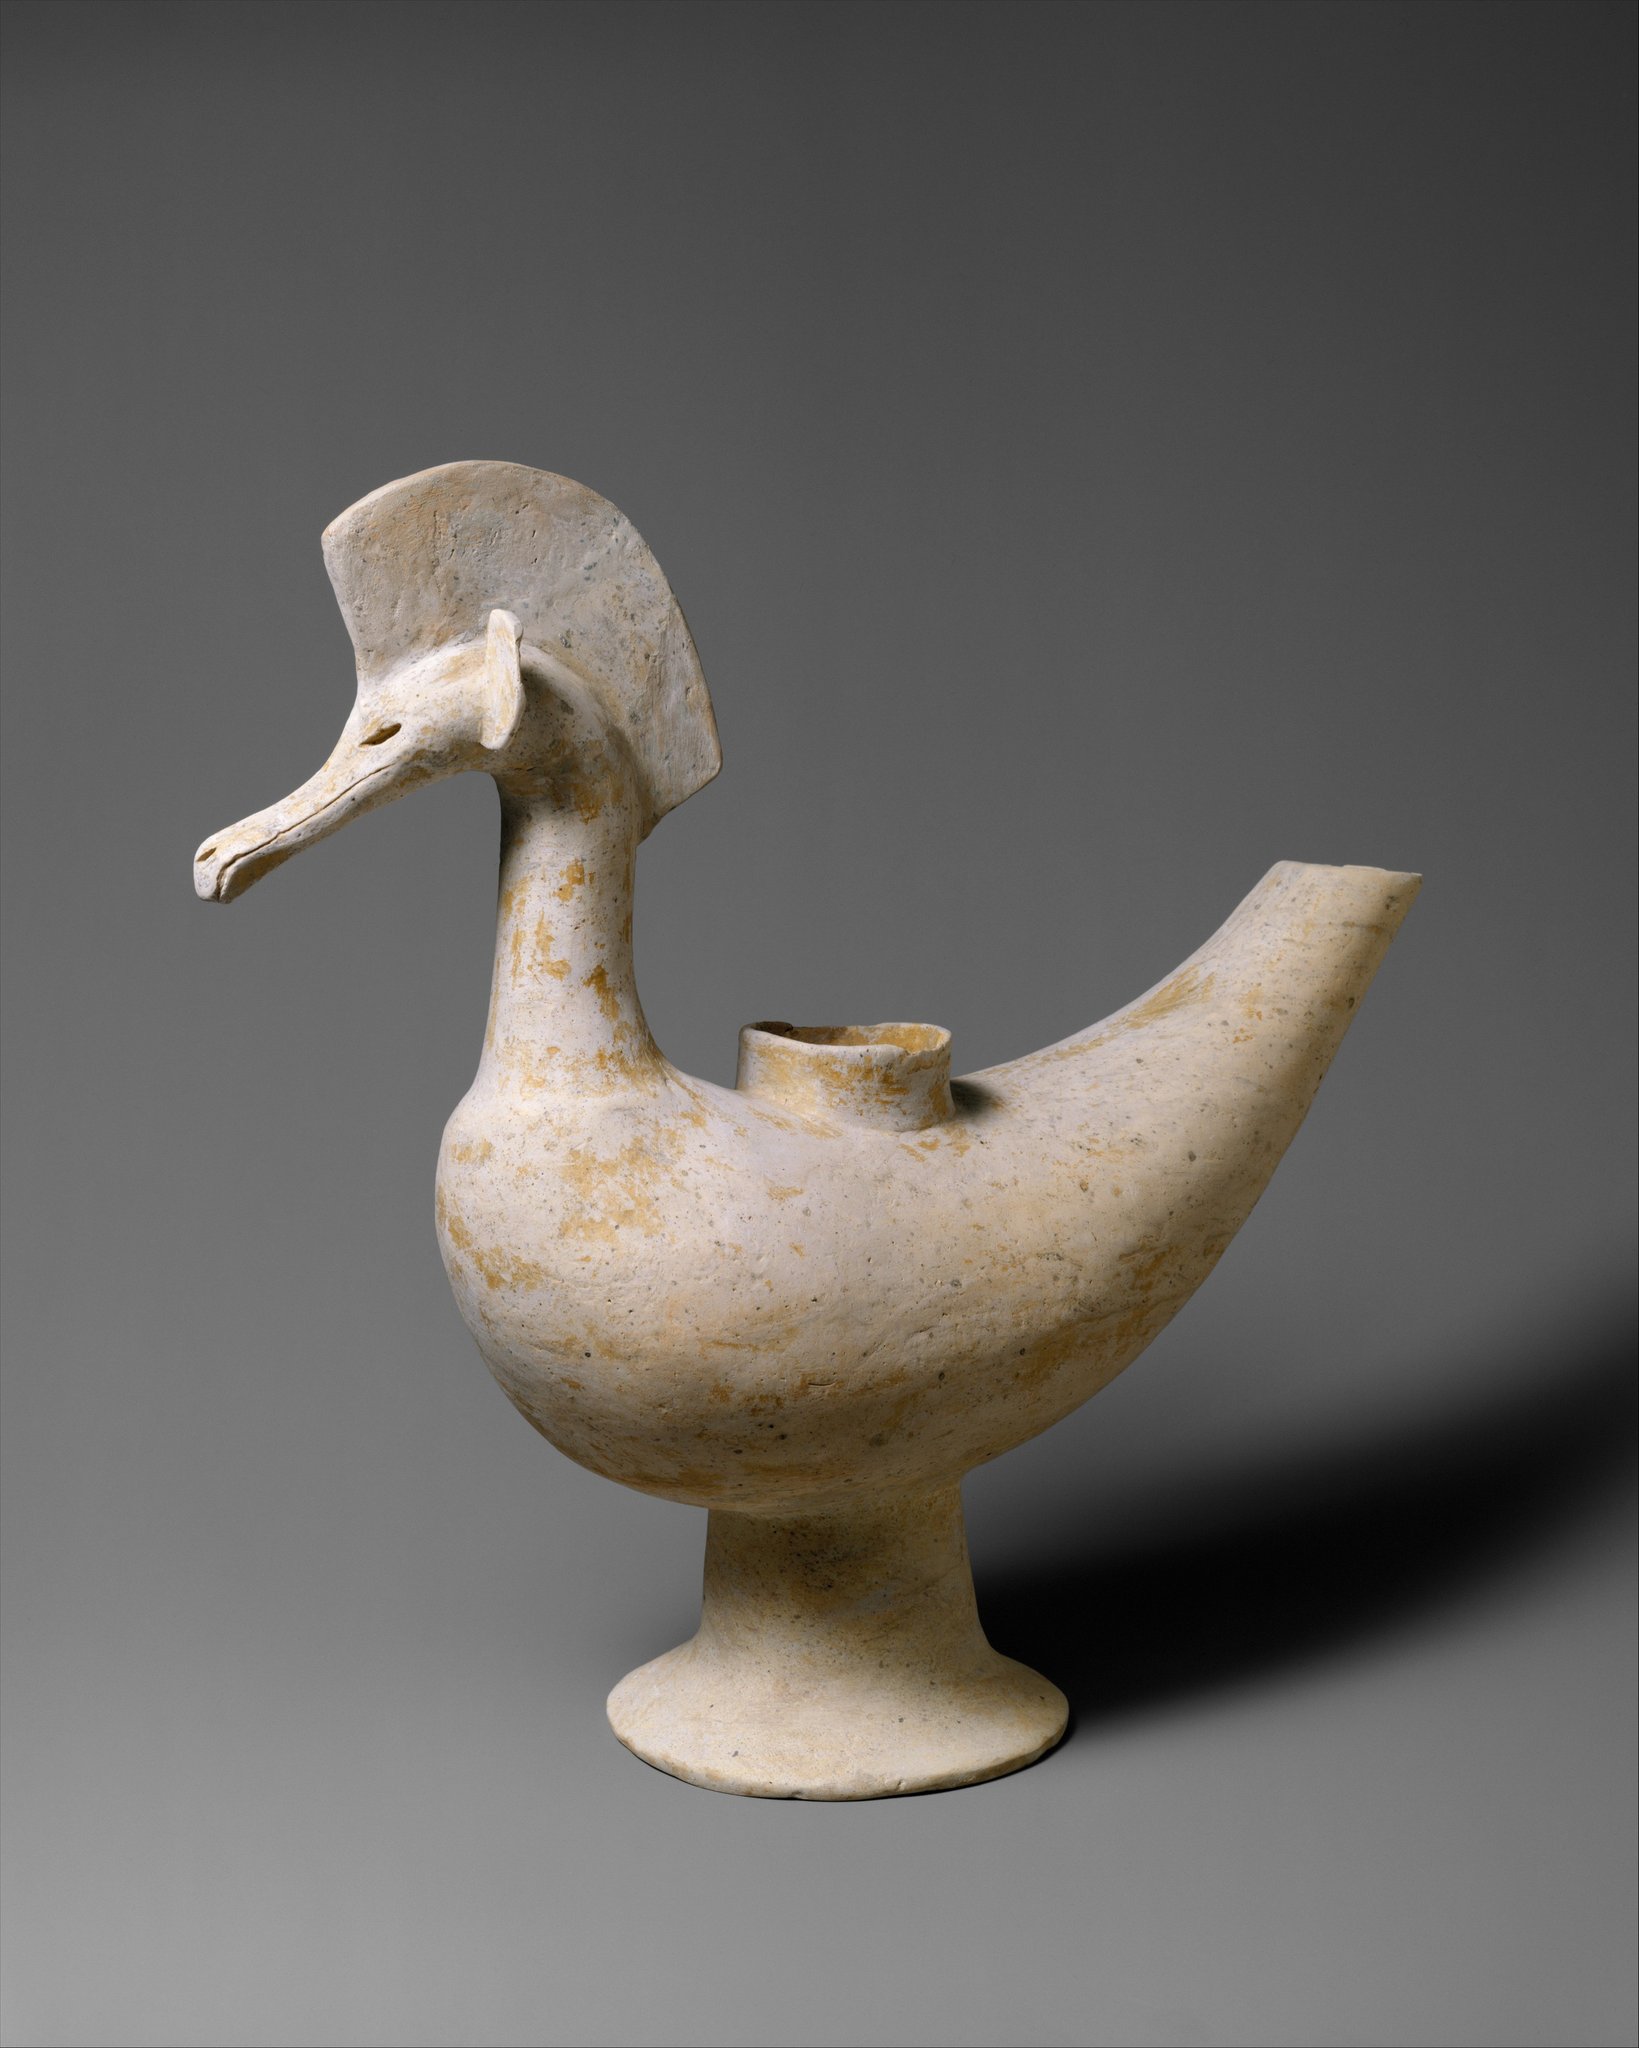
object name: vessel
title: Bird-shaped vessel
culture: korean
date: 201-300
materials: earthenware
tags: birds